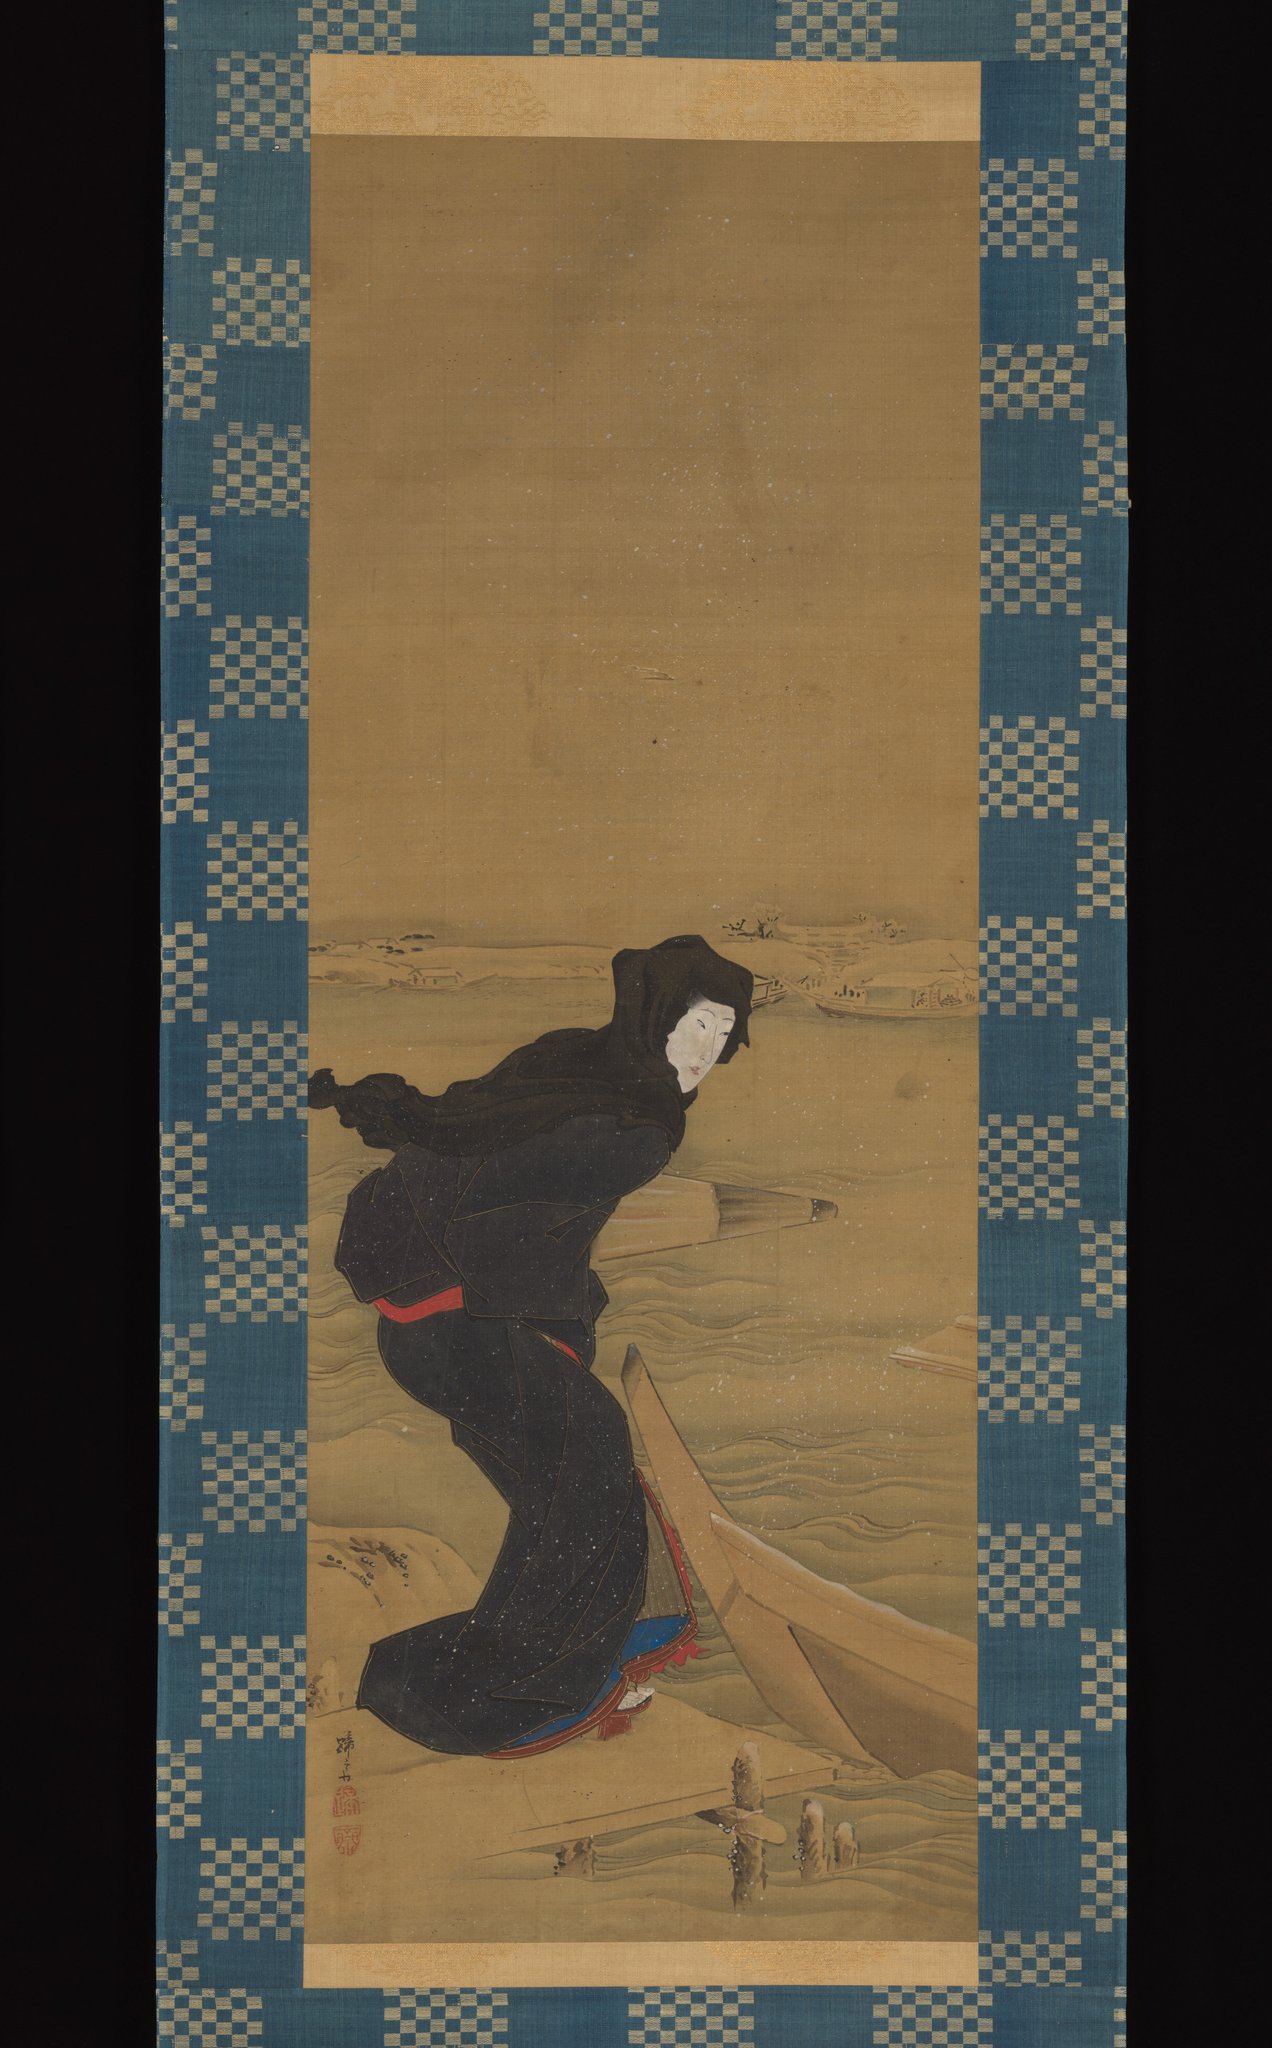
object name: hanging scroll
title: Beauty on a Snowy Quay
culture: japanese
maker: teisai hokuba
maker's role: artist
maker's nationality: japanese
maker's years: 1771-1844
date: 1701-1800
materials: gold, ink, silk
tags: women